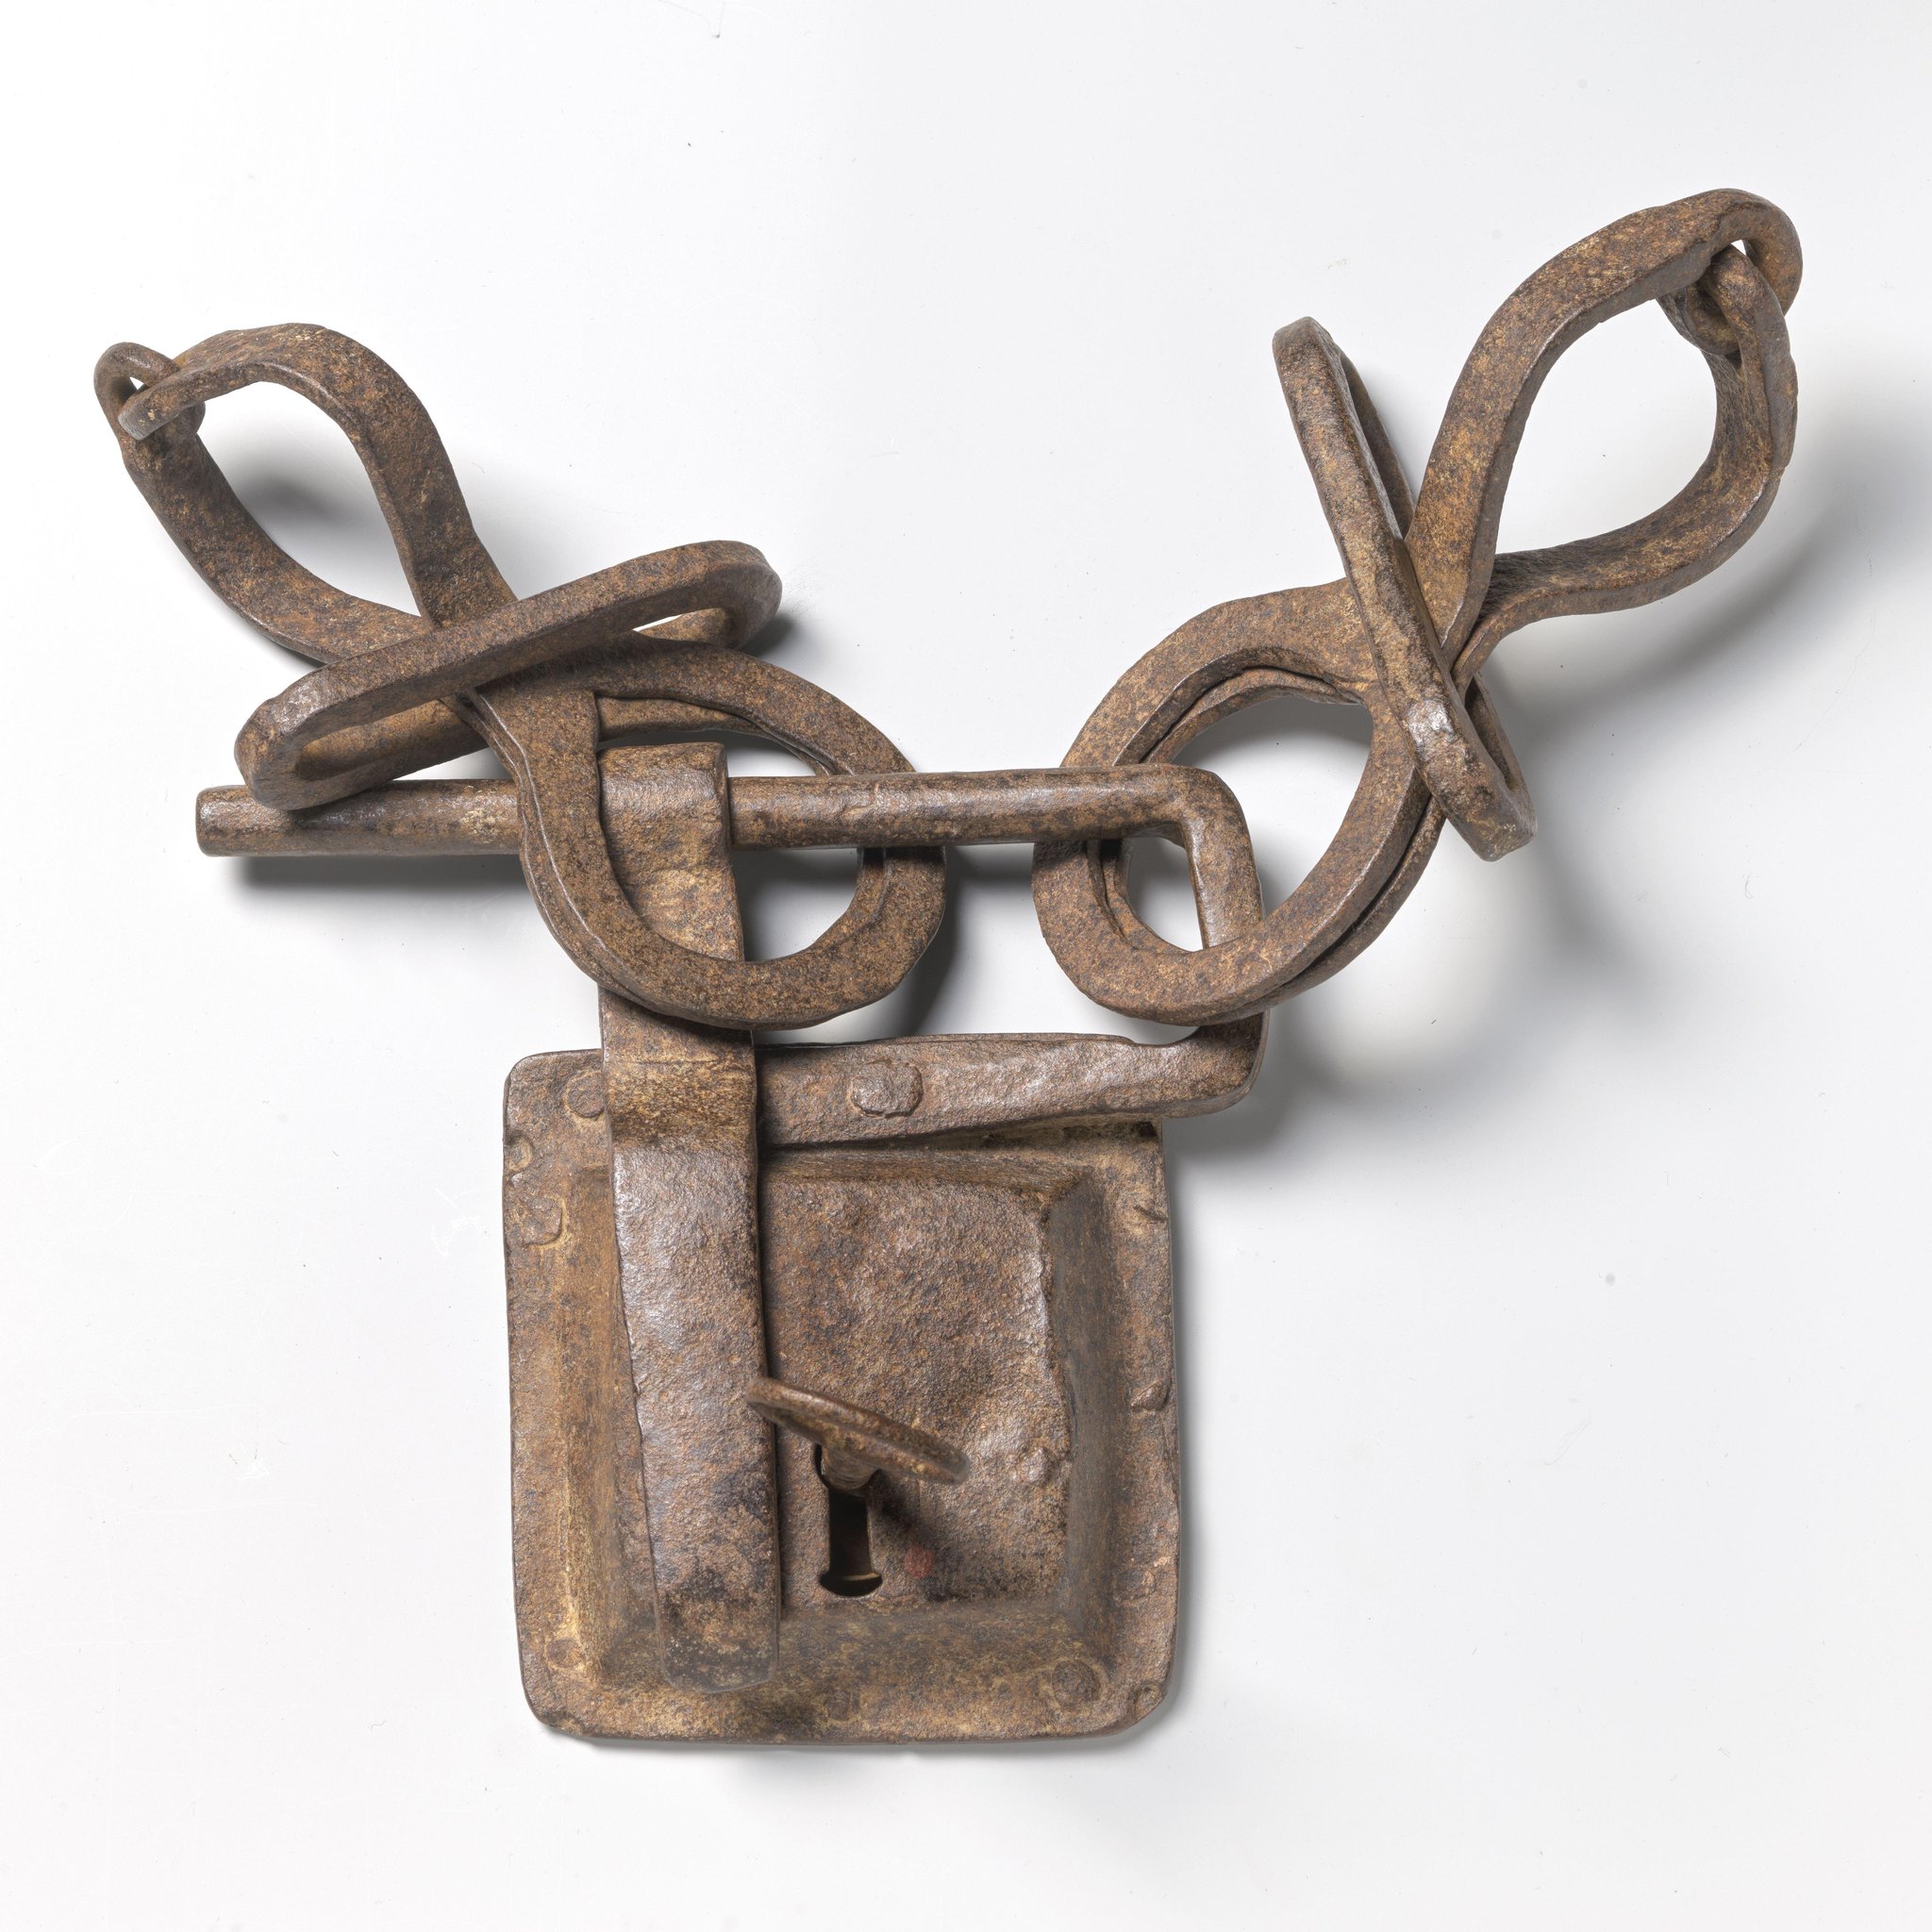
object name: voetboeien, kluister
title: Enkelboei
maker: Anonymous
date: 1600-1800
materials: iron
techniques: forging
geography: netherlands